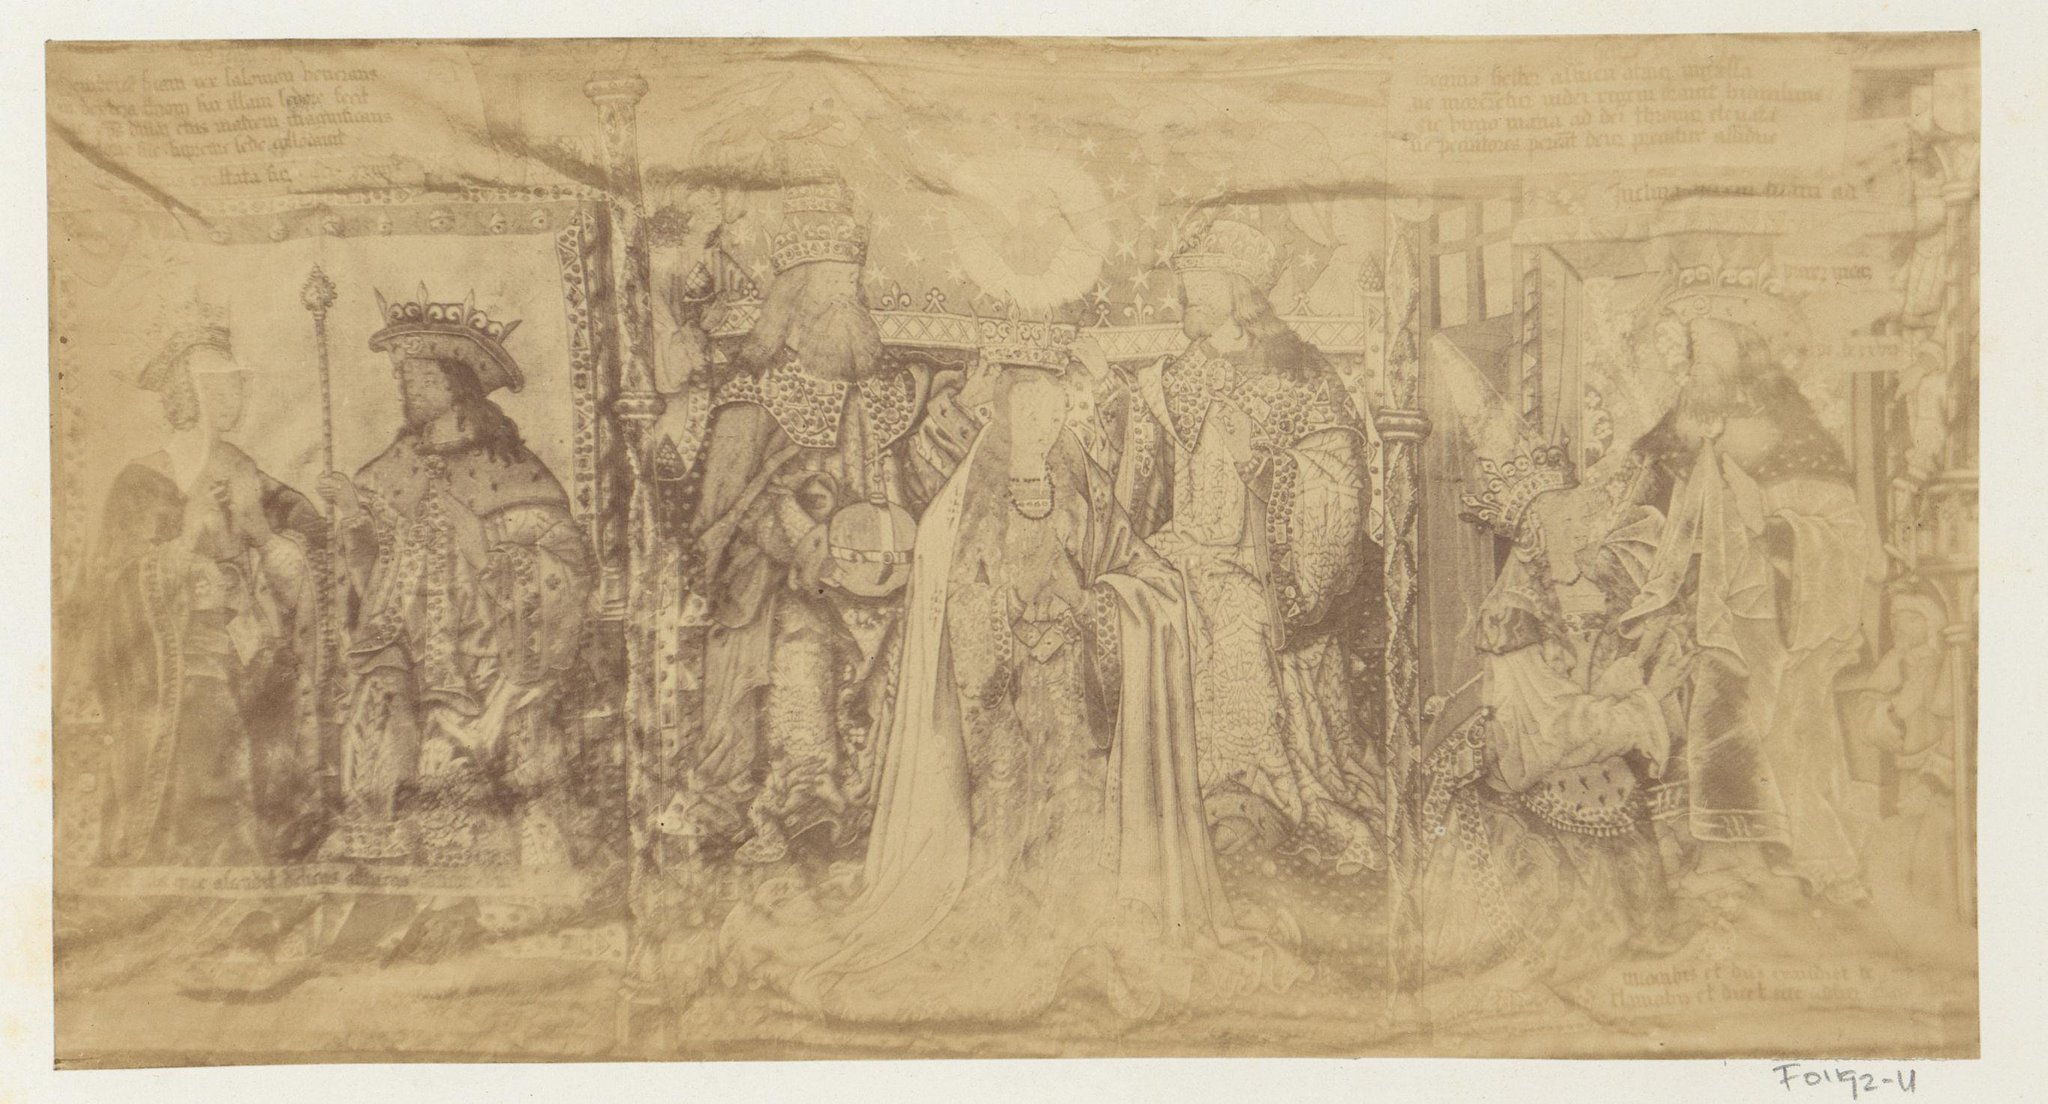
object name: photograph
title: Tapijt met gekroonde Maria en prefiguraties in een kerk te La Chaise-Dieu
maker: hippolyte malègue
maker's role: archeoloog, fotograaf, schrijver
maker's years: 1825-1901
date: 1868-1873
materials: photographic support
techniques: albumen print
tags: tapestry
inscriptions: inscription: ‘album des tapisseries de l'église de la Chaise-Dieu, par M. H. Malegue - Planche XXI’